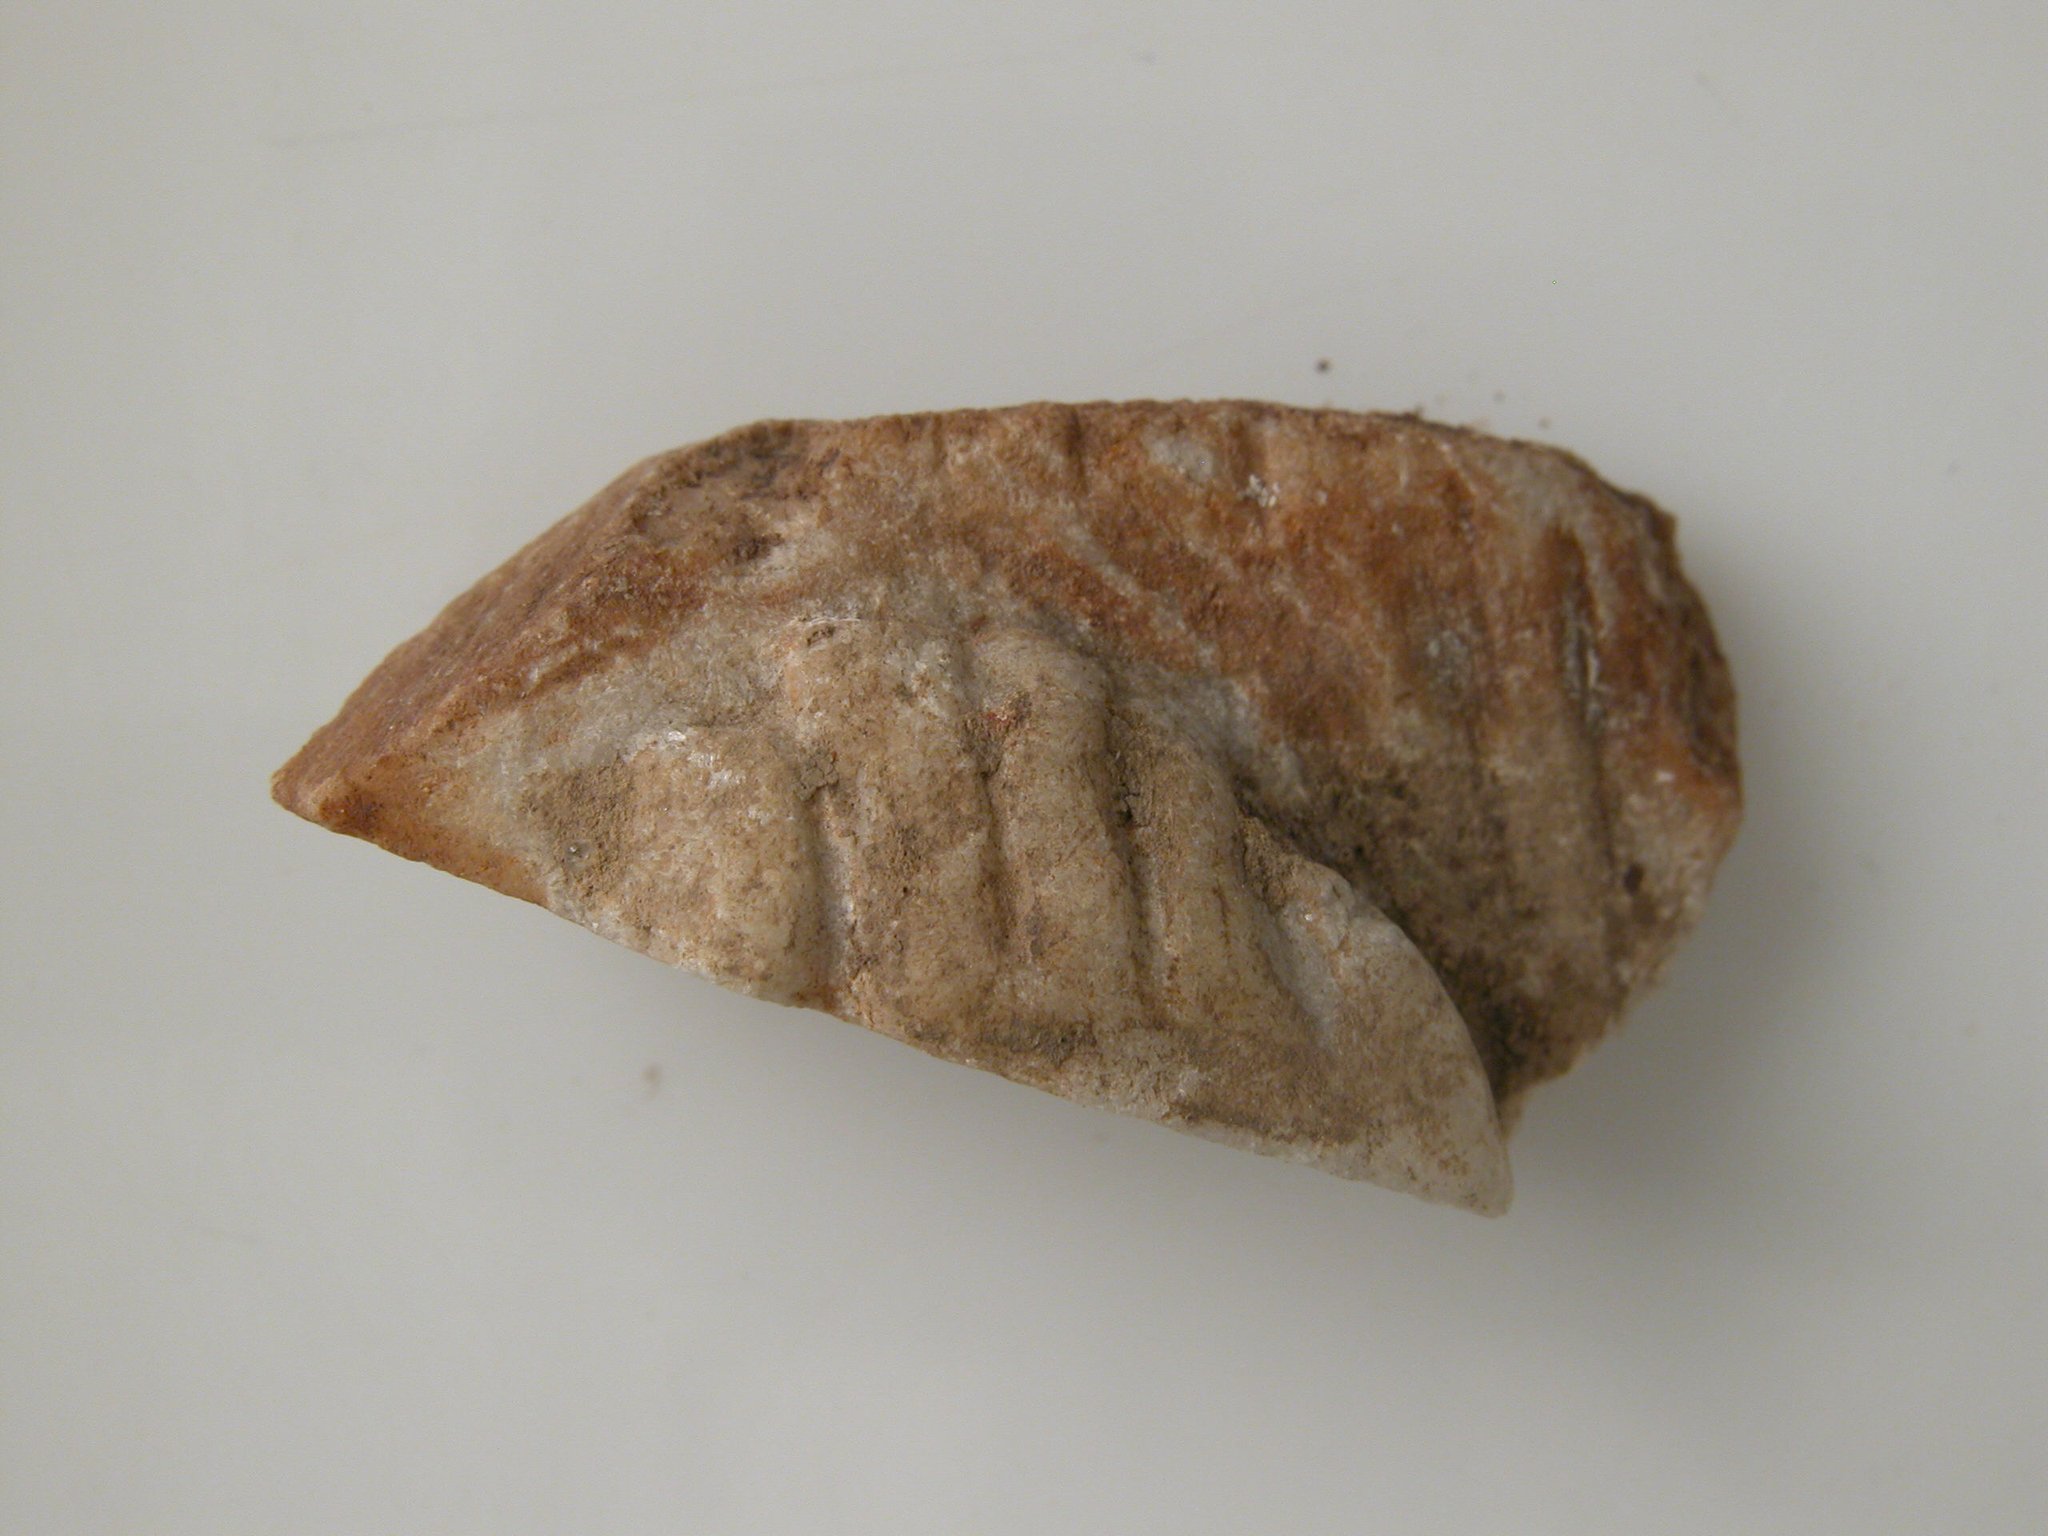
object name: statuette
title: Foot Fragment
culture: coptic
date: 301-700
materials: stone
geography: egypt